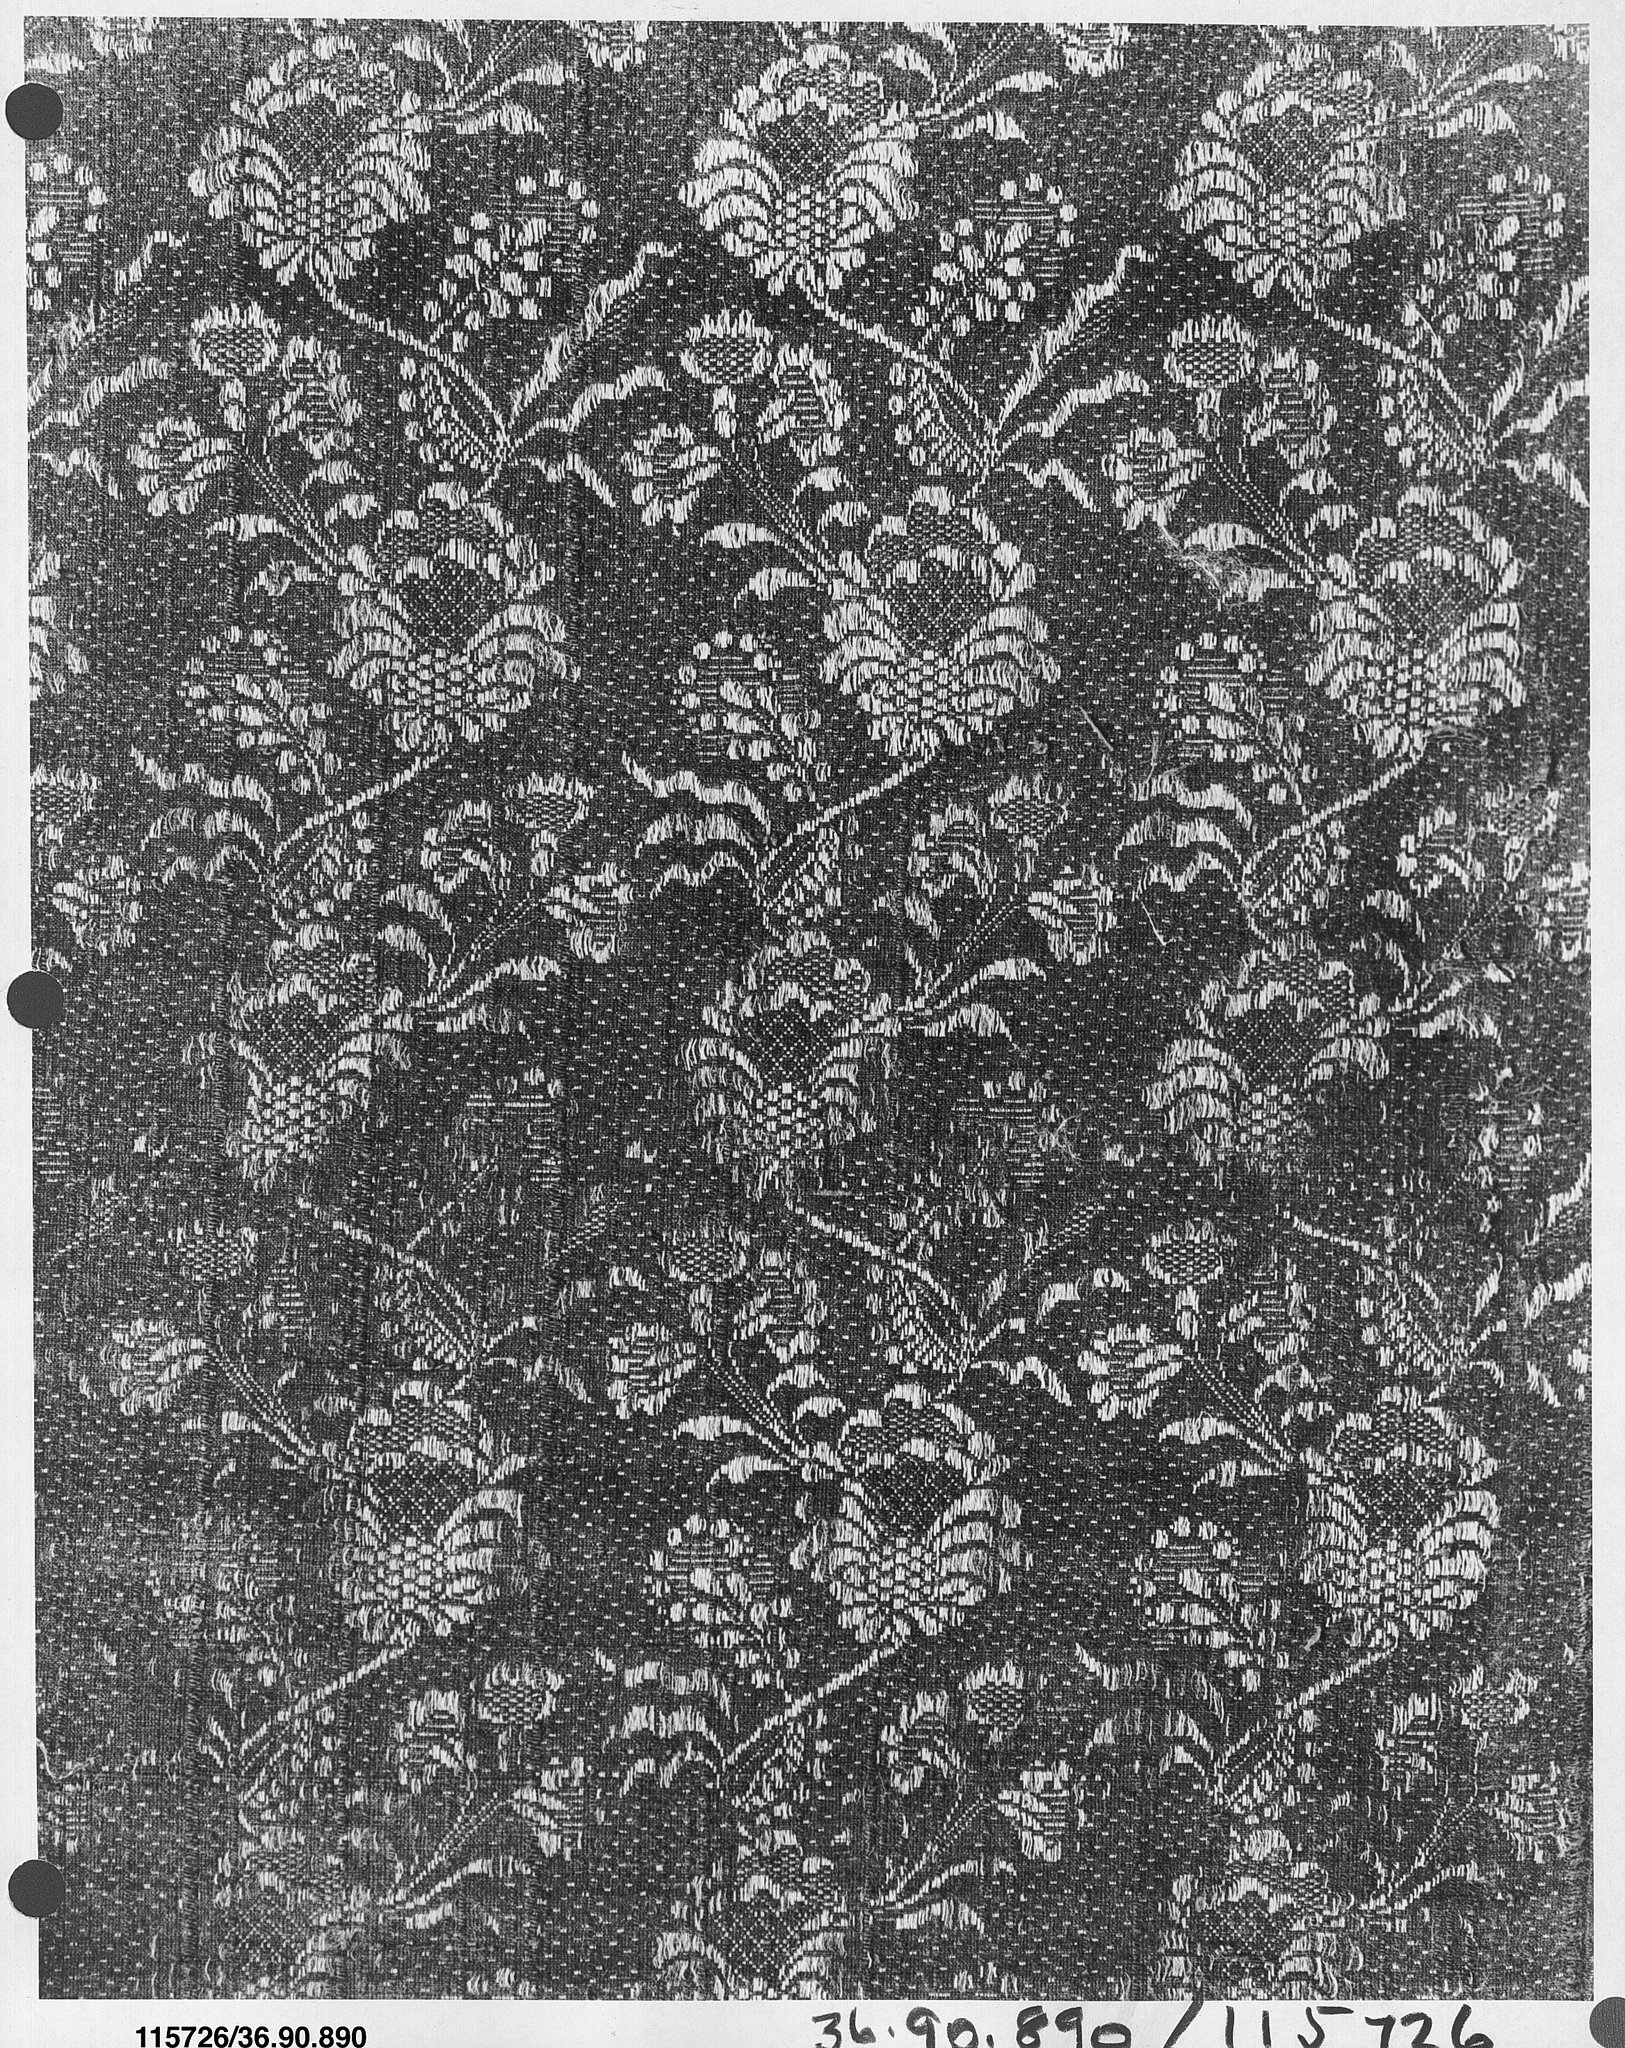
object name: piece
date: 1760-1770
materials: silk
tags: flowers,leaves